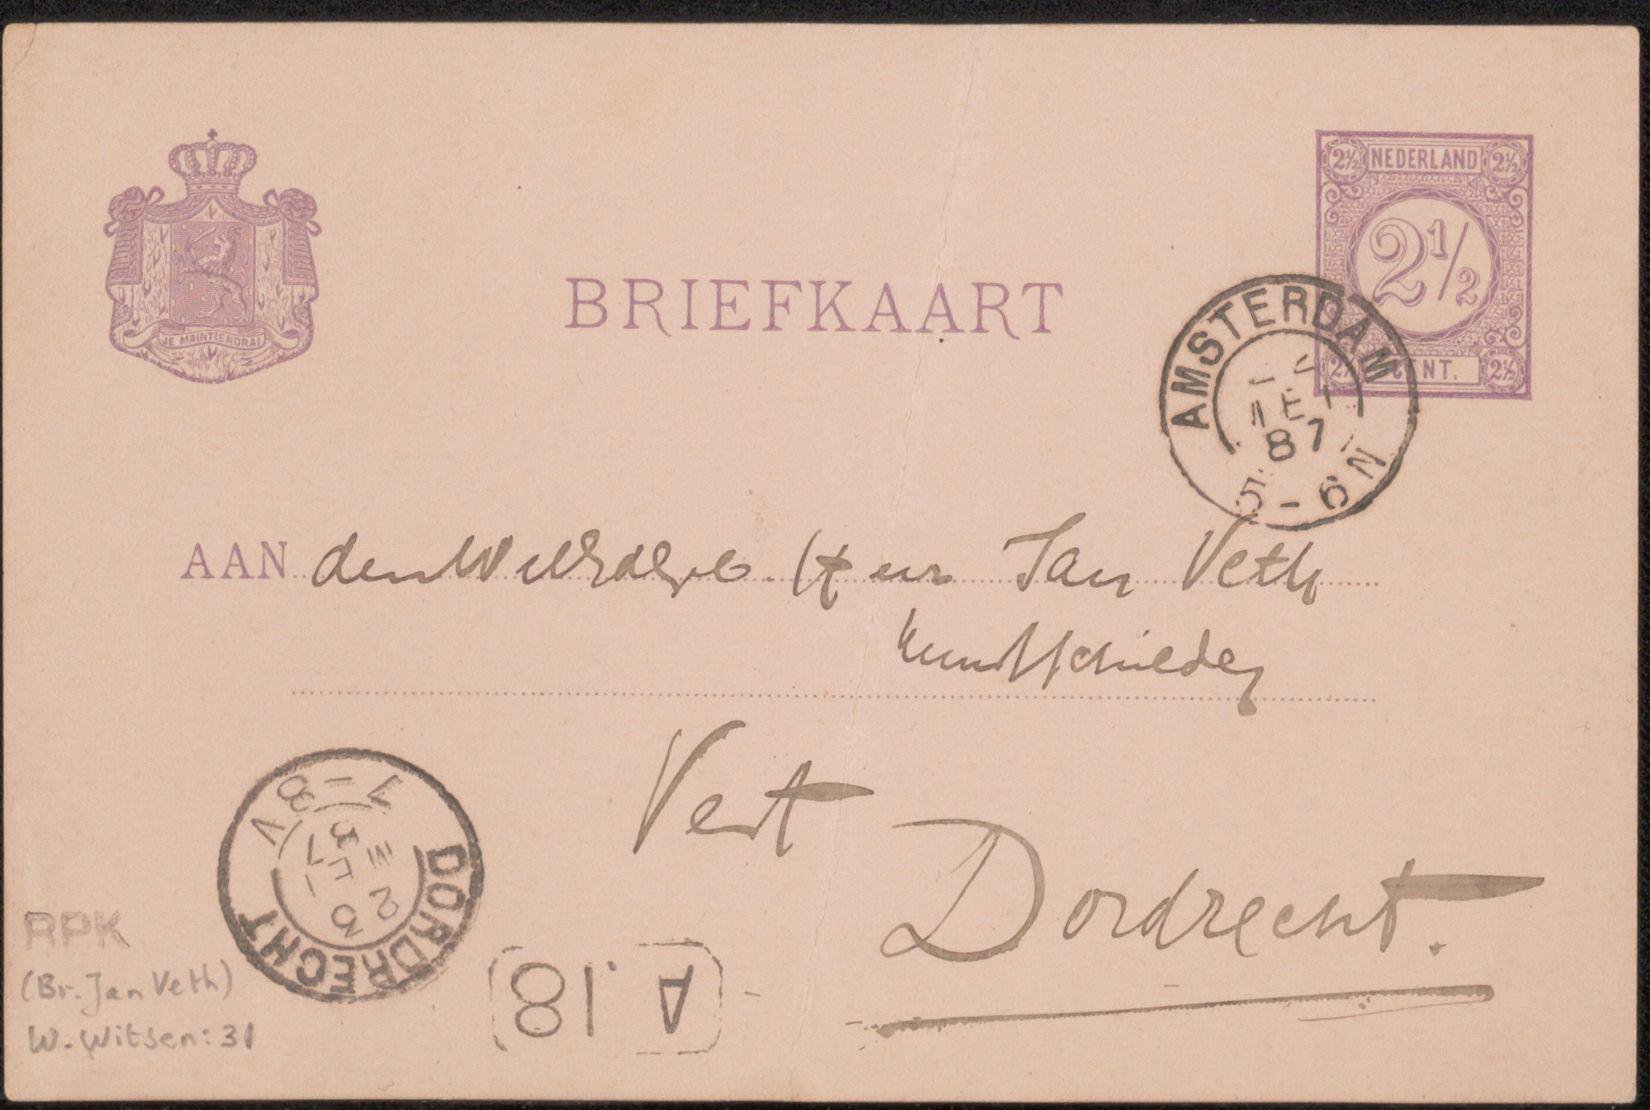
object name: postcard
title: Briefkaart aan Jan Veth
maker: willem witsen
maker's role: draughtsman, painter, print maker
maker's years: 1860-1923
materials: cardboard, ink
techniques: pen, writing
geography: amsterdam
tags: dordrecht, designer, jan veth, historical persons (portraits and scenes from the life), the hague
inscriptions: collector's mark: ‘RPK’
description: Briefkaart gedateerd 23 Mei 87 in latere hand.